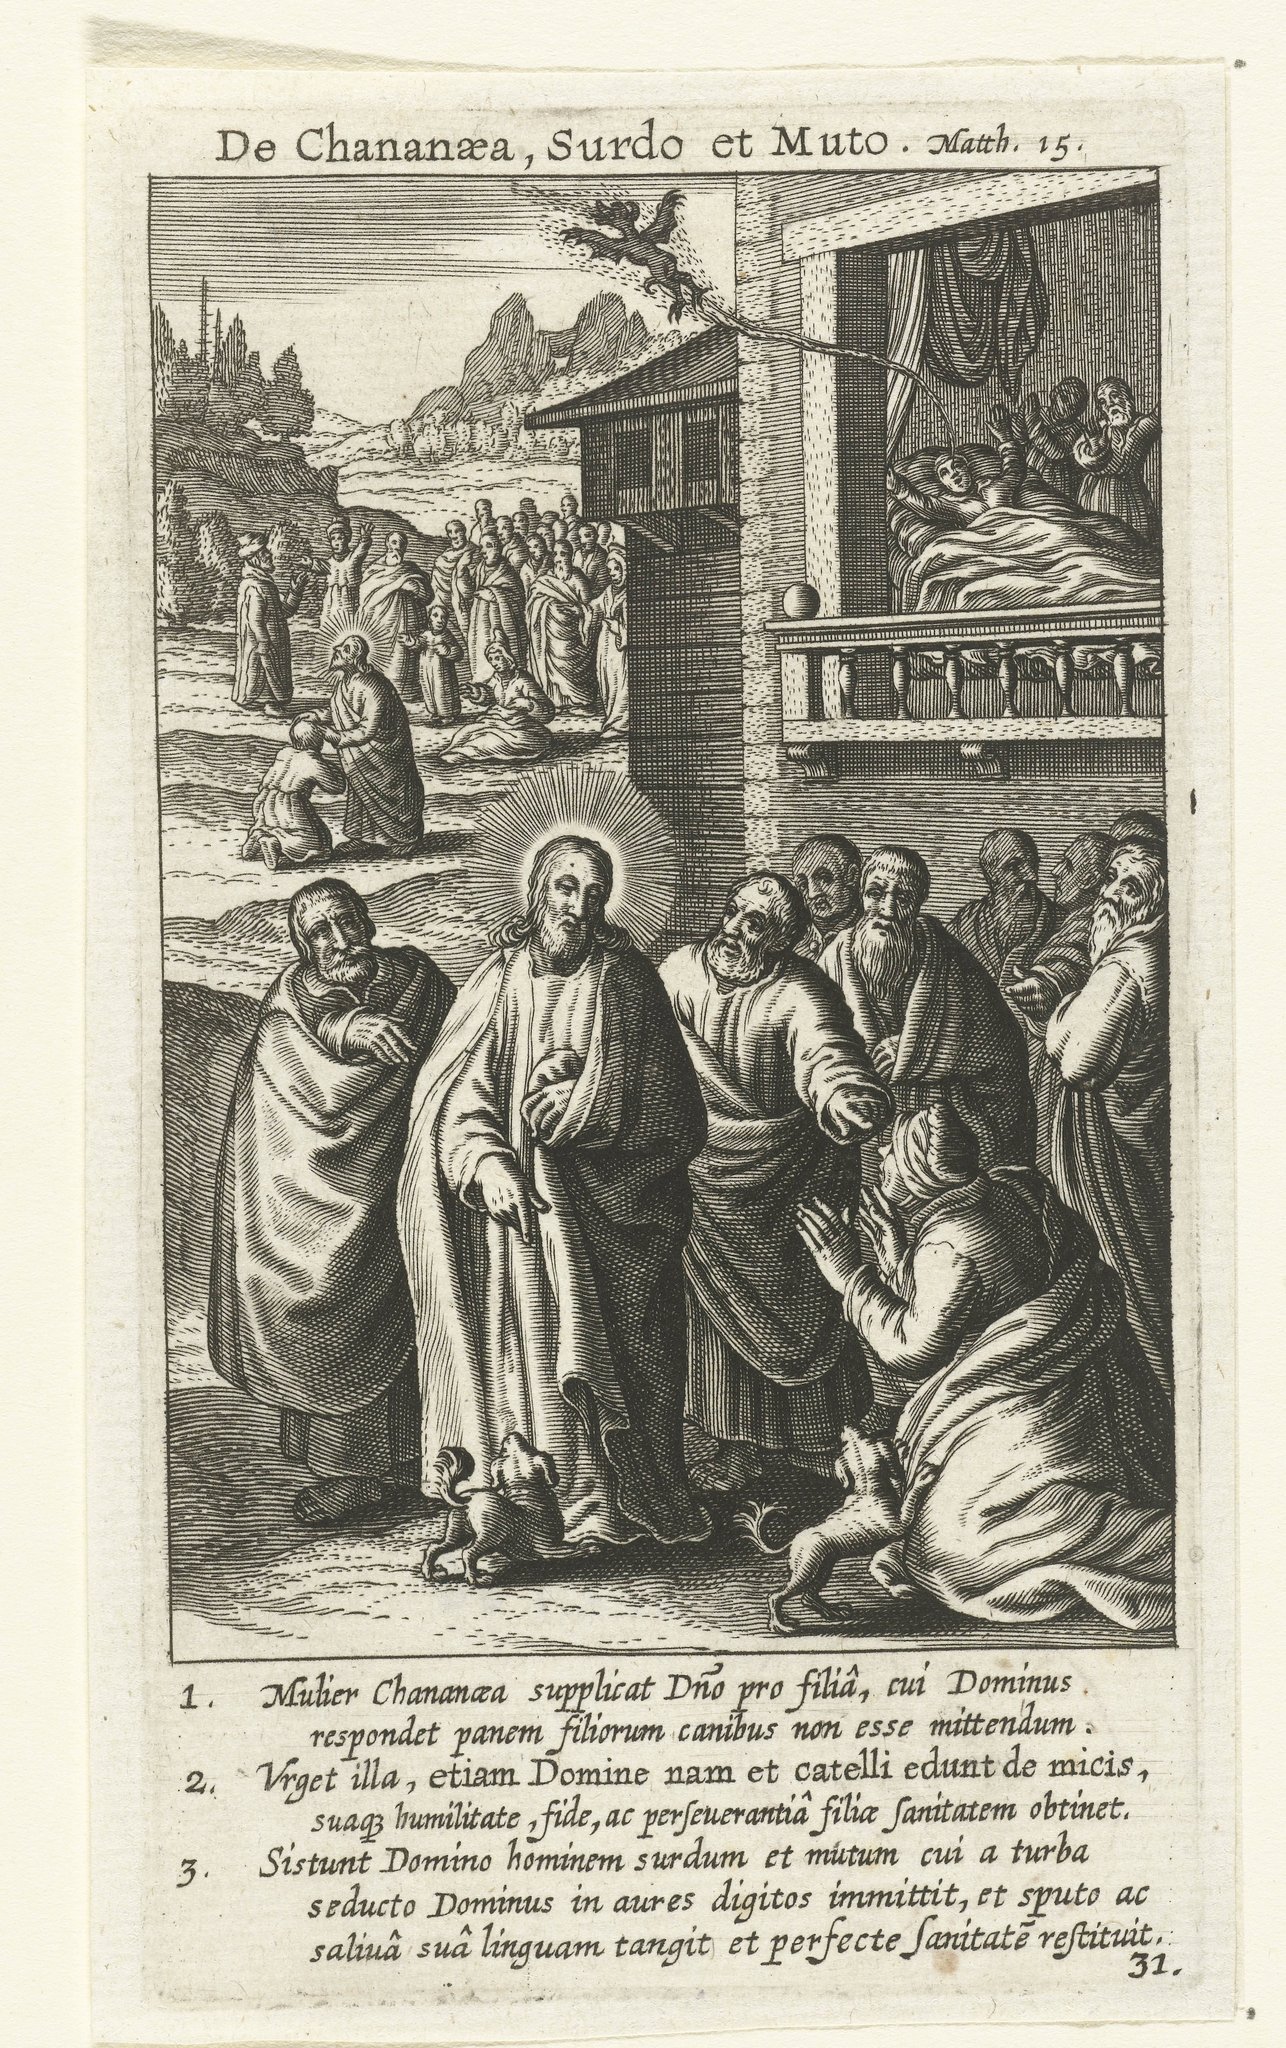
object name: print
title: Vitae passionis et mortis Jesu Christ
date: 1590-1622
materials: paper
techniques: engraving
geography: antwerp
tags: a canaanite woman kneels before christ, asking him to heal her daughter; the metaphor of the dogs and bread (matthew 15:21-28; mark 7:24-30)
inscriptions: collector's mark: Lugt 240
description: Prent uit: Joannes Bourgois, Vitae passionis et mortis Jesu Christi Somini nostri mysteria, Antwerpen Hendrick Aertssens, 1622, afb. 31